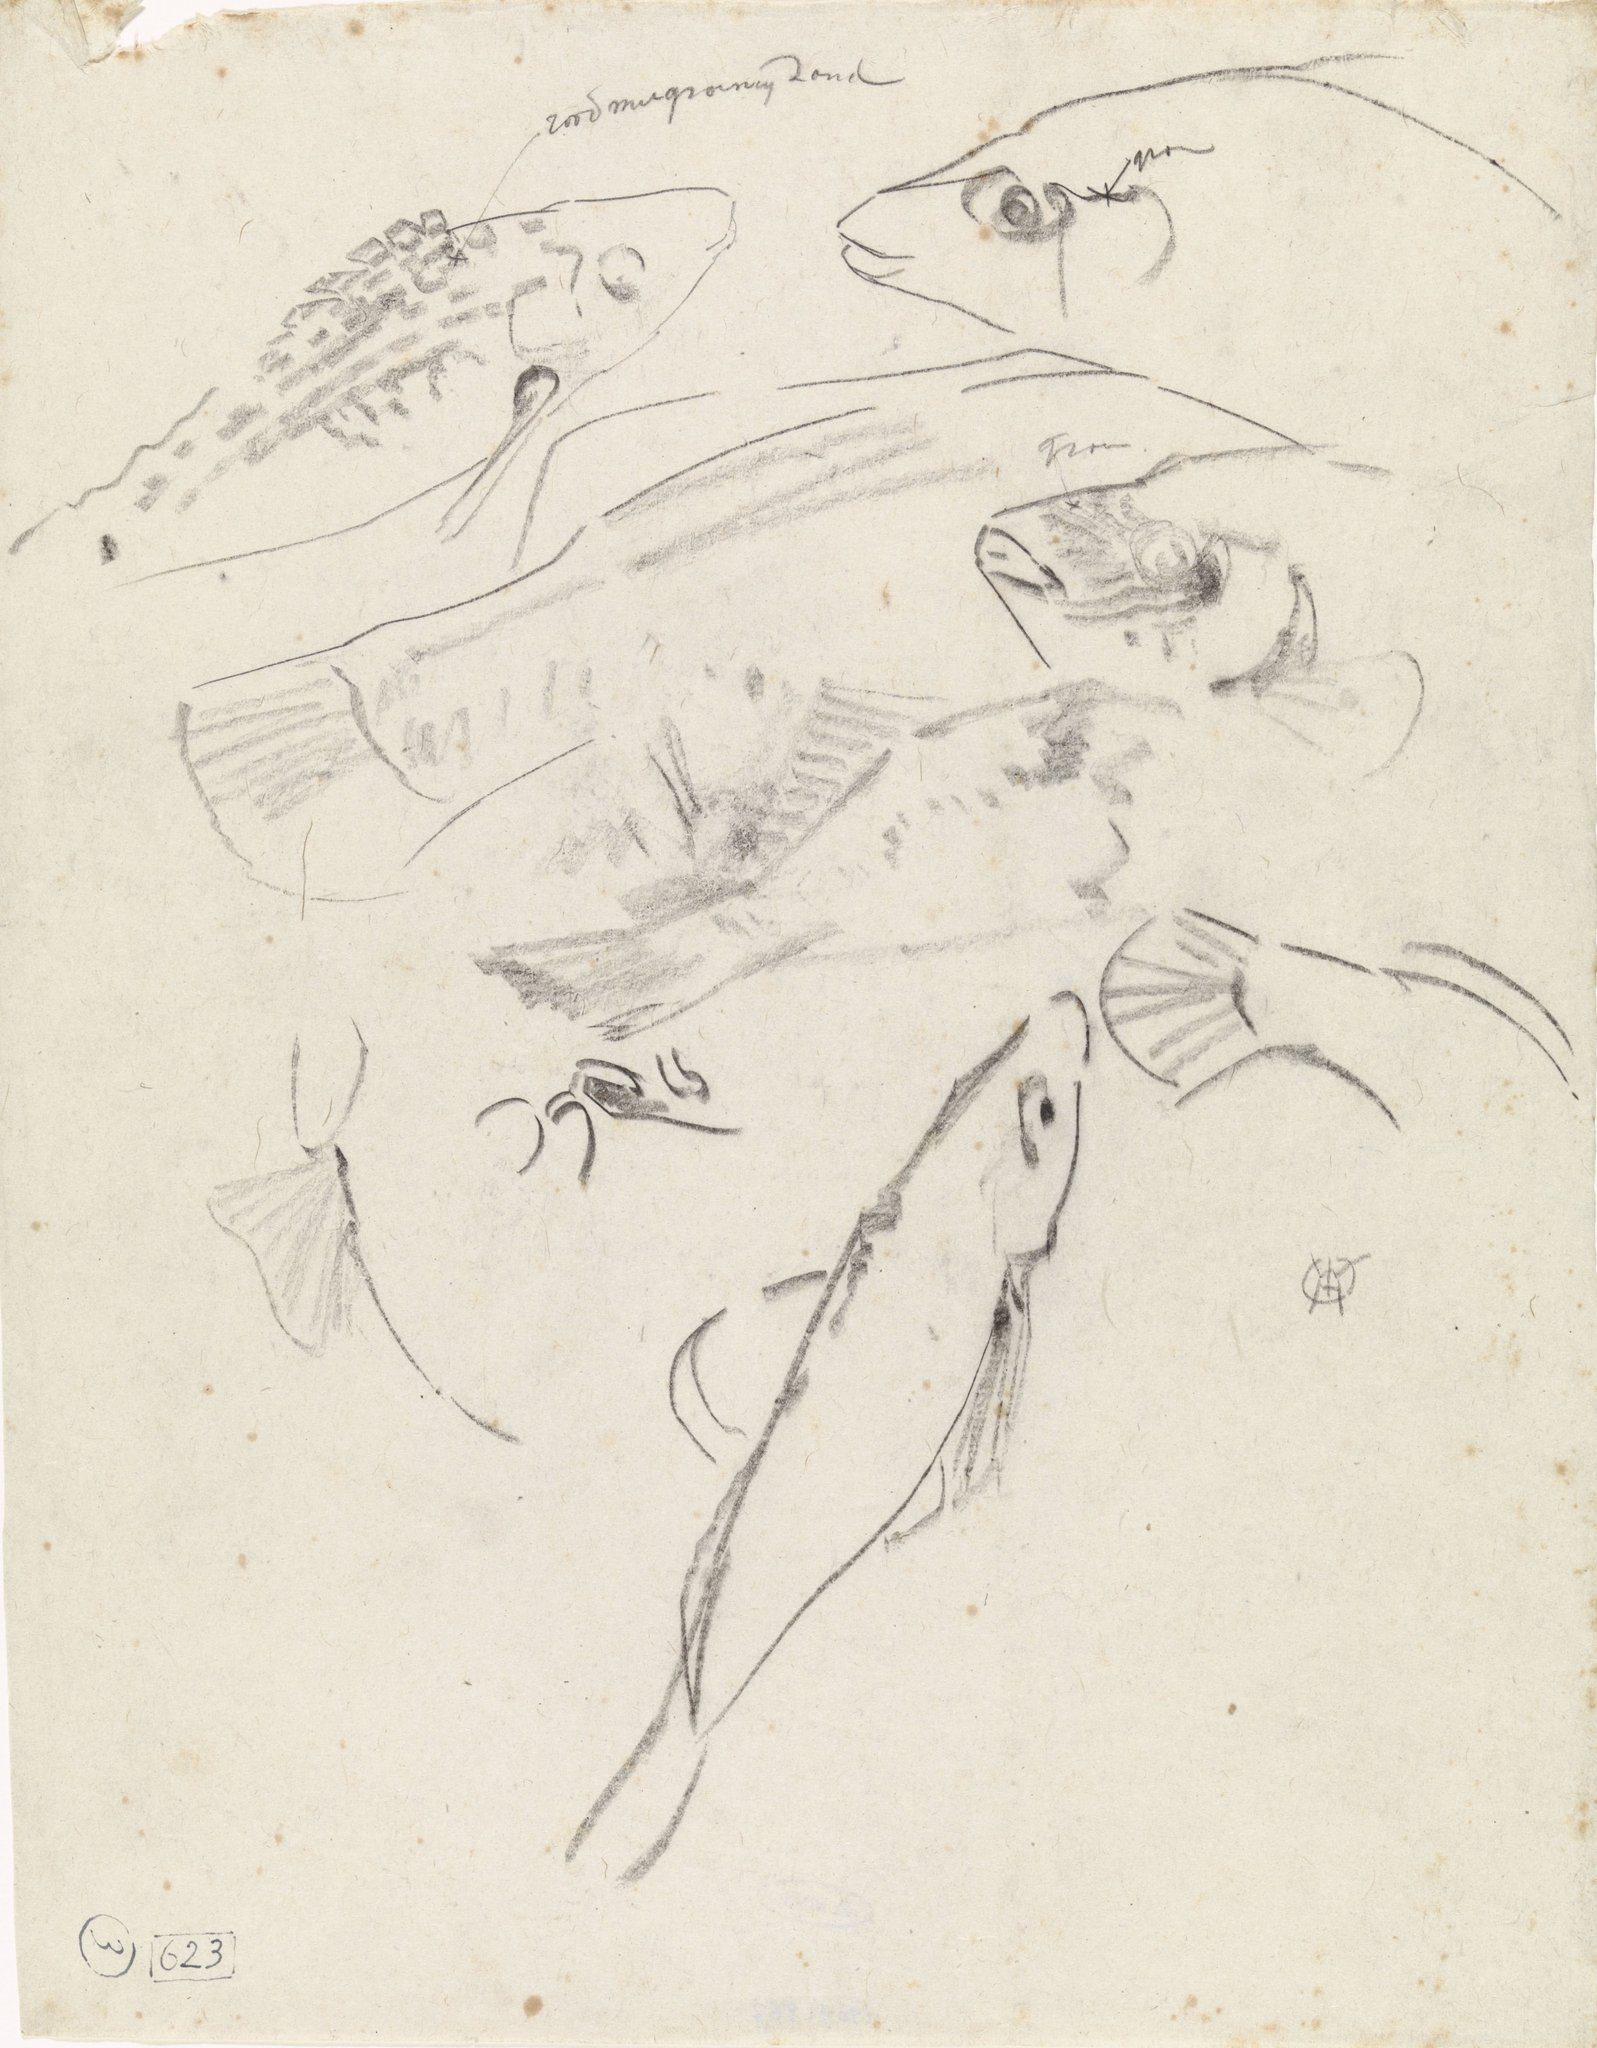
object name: drawing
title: Studies van vissen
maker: gerrit willem dijsselhof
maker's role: designer, draughtsman, print maker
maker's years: 1866-1924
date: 1876-1924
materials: chalk, paper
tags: bony fishes